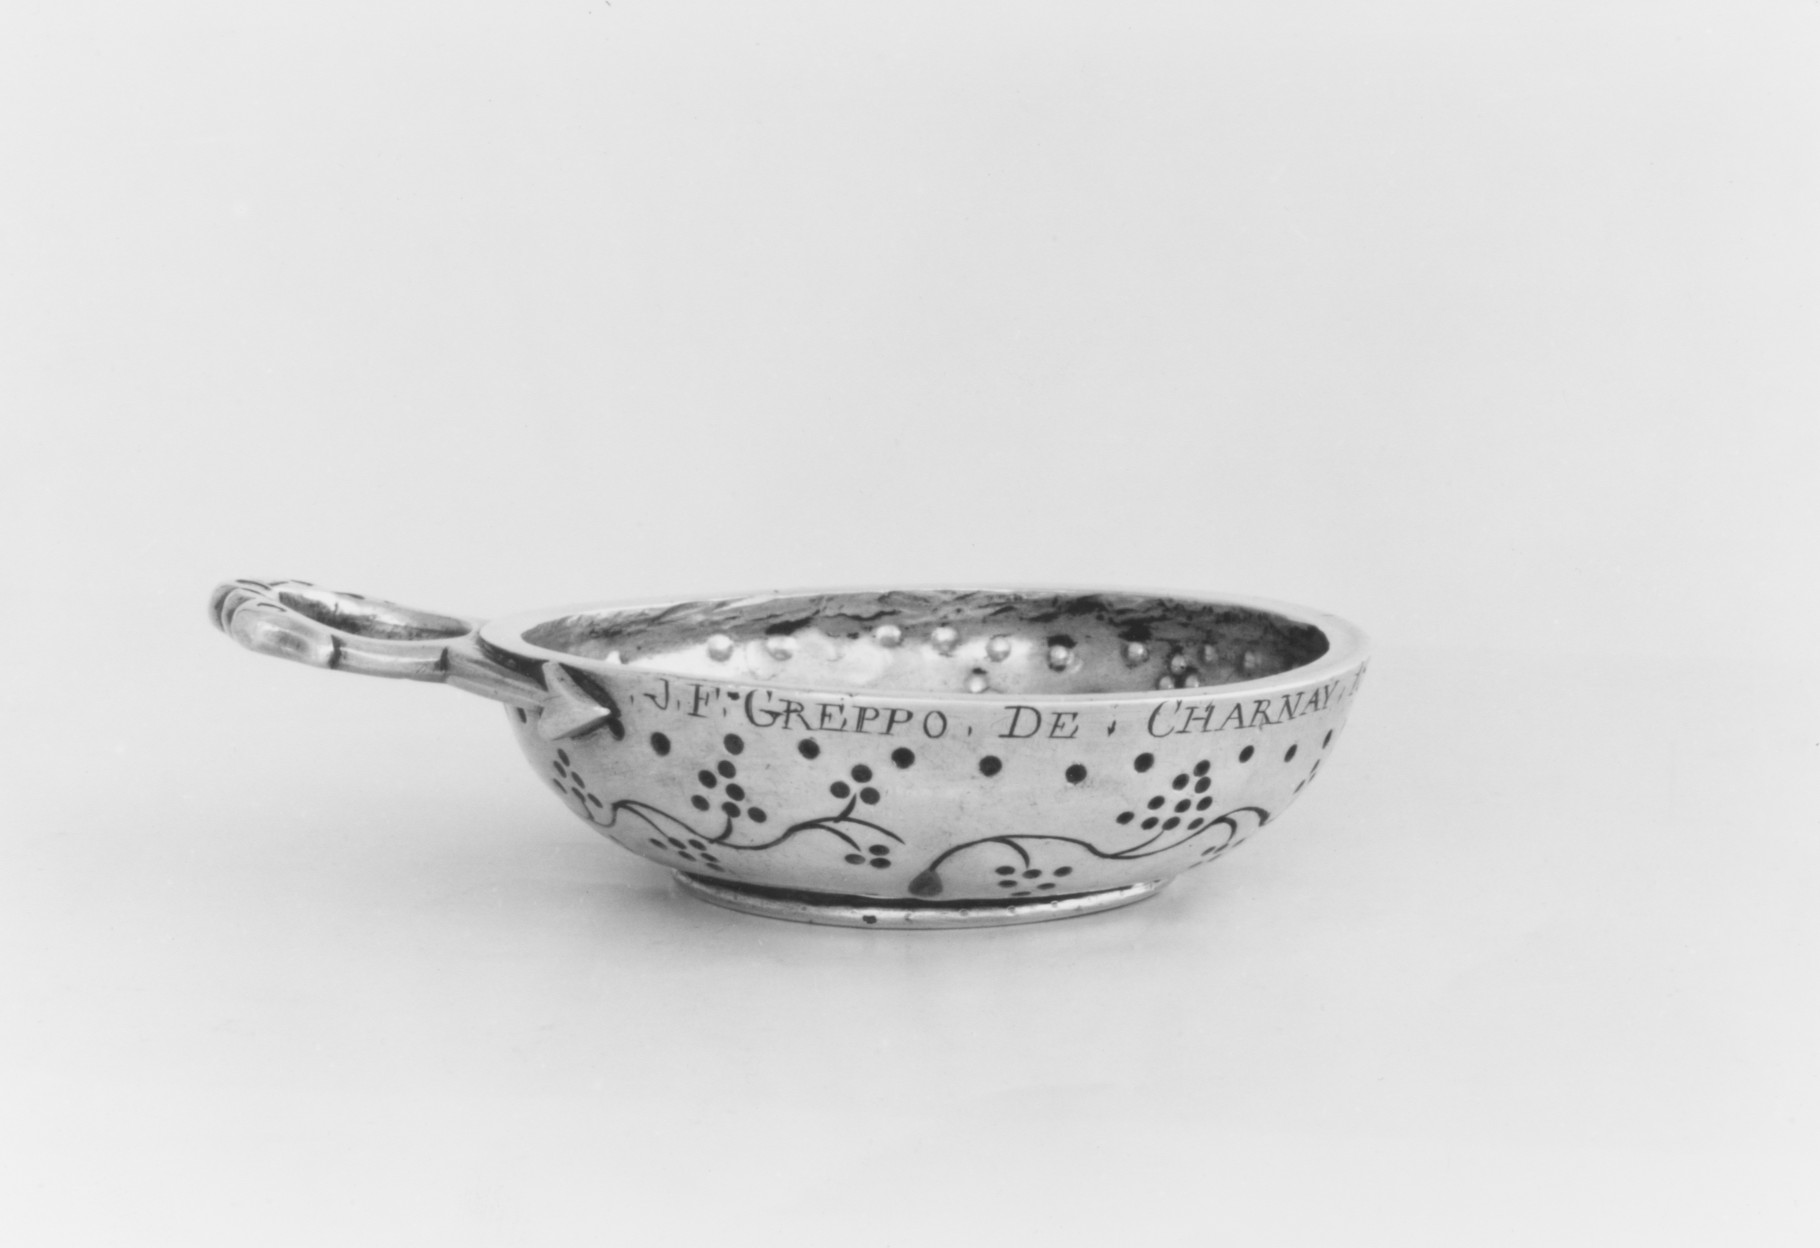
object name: wine taster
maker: a.l., france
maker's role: maker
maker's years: 1750-1850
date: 1780-1790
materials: silver